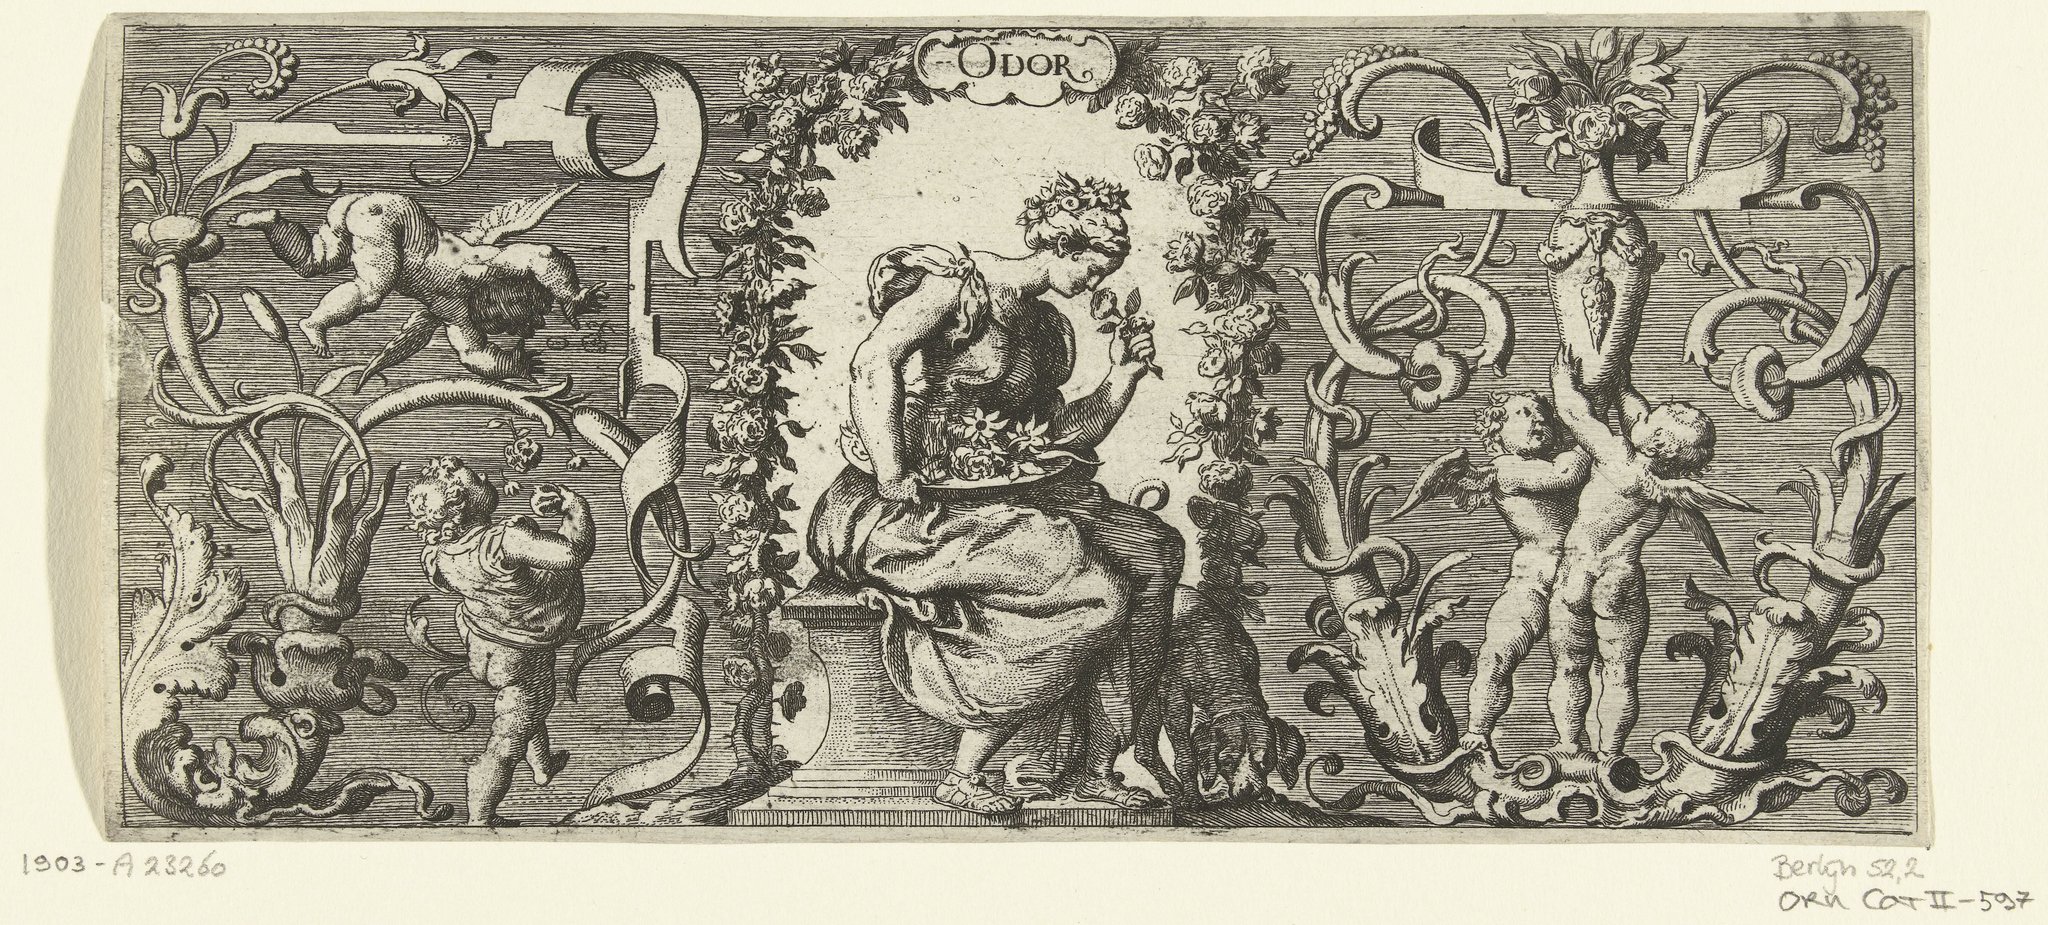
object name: ornament print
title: Quinque Sensuum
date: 1655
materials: paper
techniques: etching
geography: england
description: Een vrouw ruikt aan een bloem afkomstig van een schaal met bloemen op haar schoot. Blad uit serie bestaande uit een titelblad en 5 bladen met personificaties van de zintuigen, derde editie.